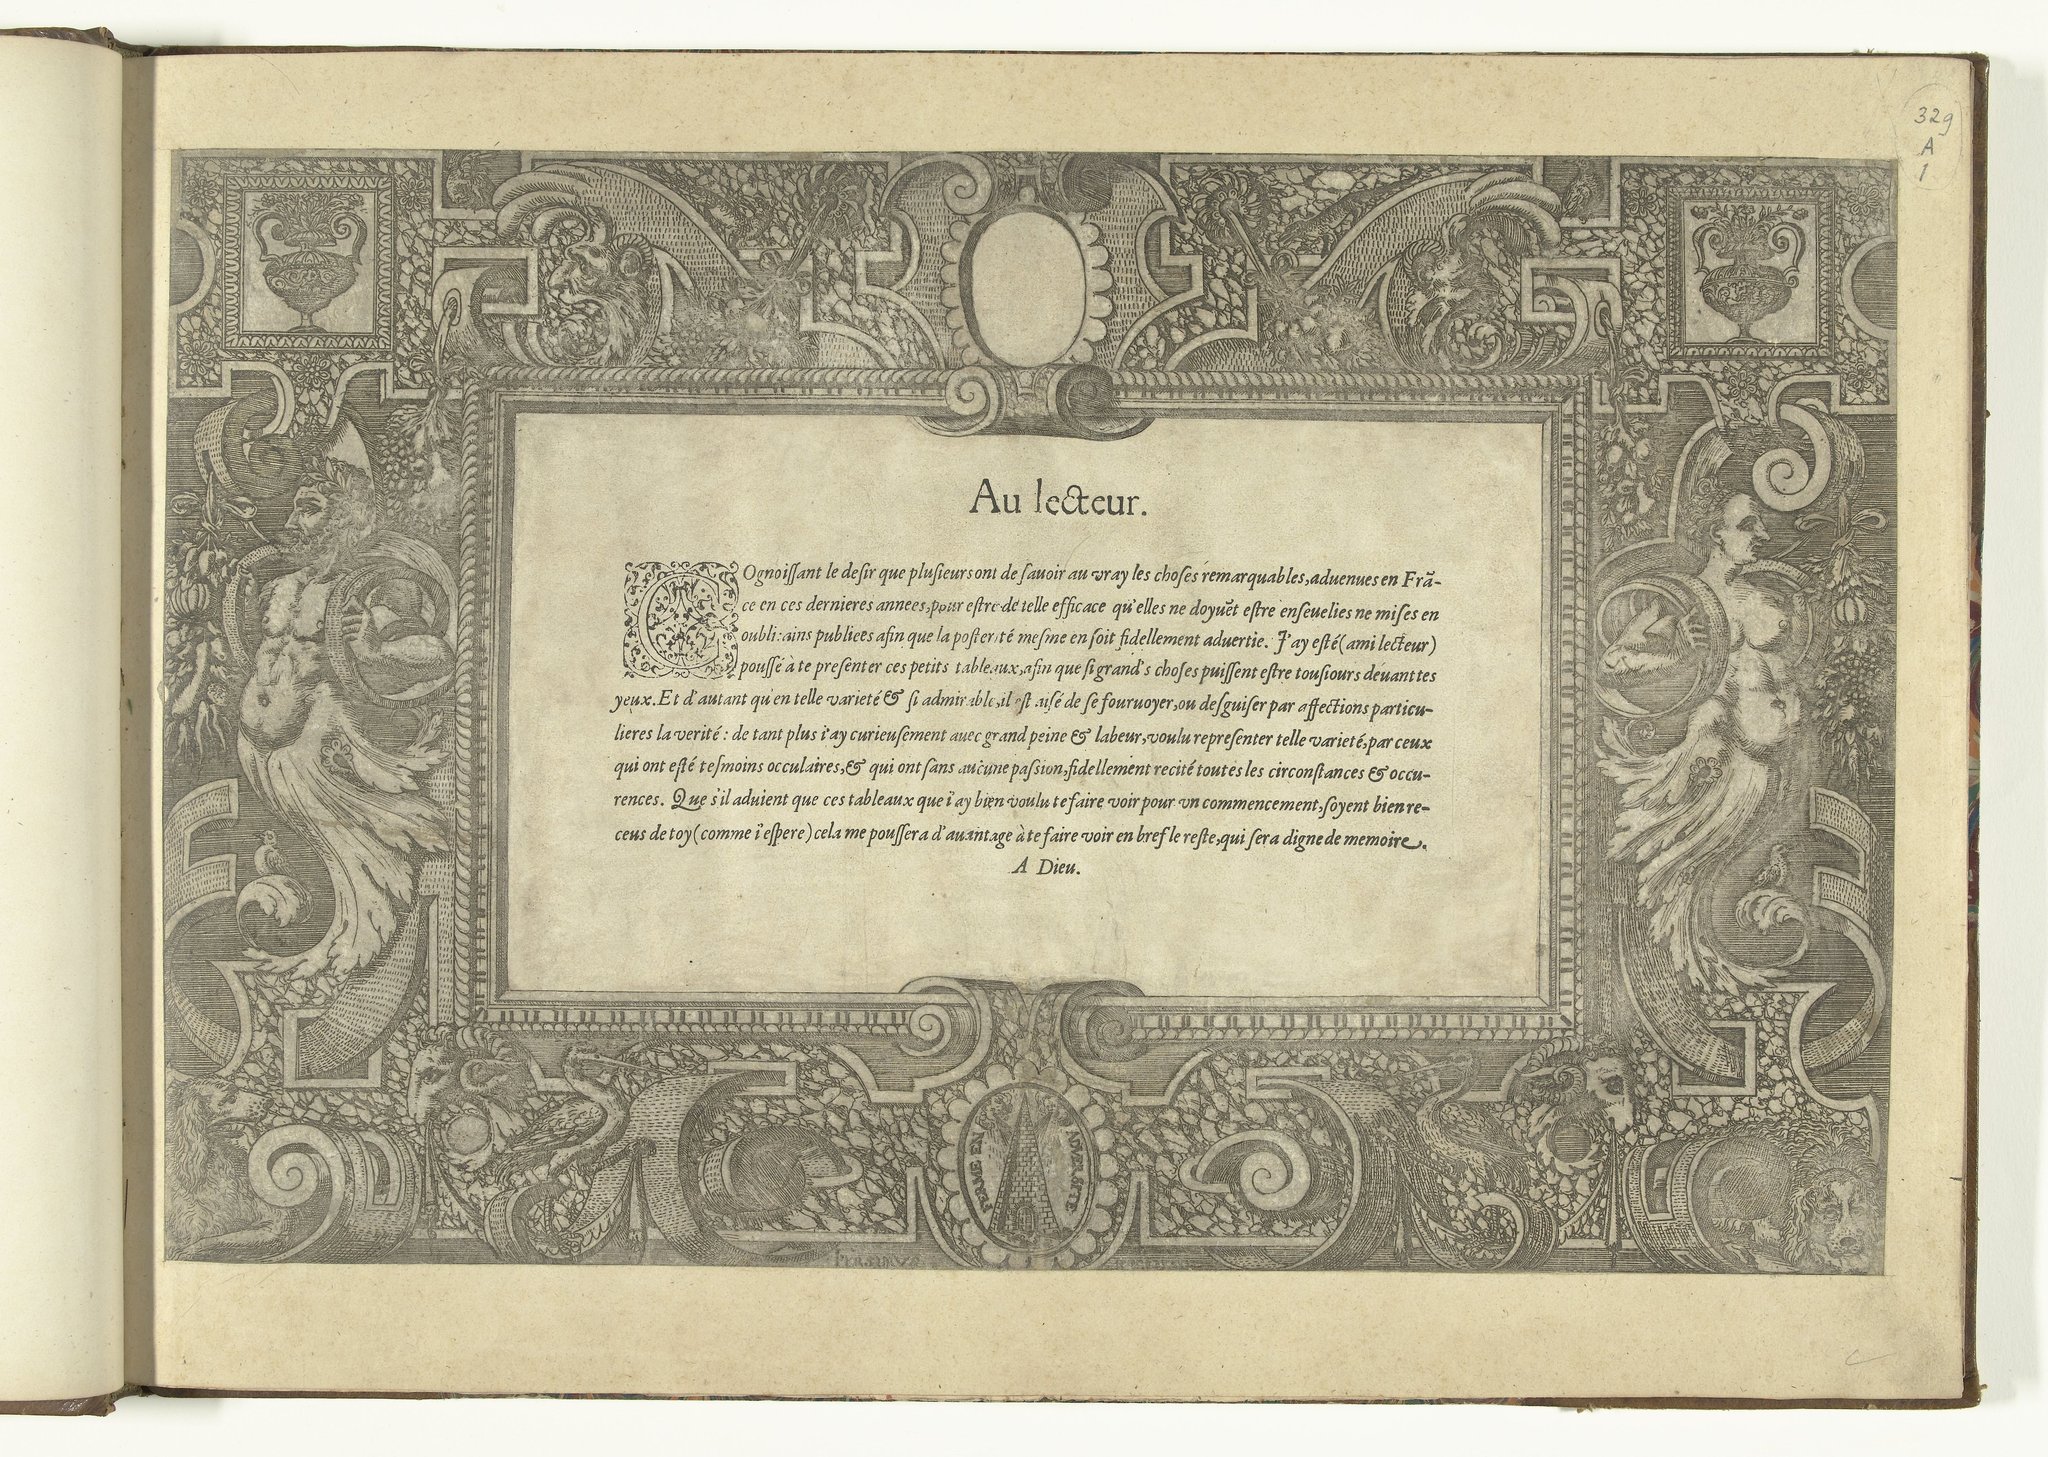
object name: print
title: Opdracht aan de lezer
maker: jean perrissin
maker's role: print maker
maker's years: 1536-1611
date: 1570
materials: paper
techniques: etching, letterpress printing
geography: france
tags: ornaments ~ art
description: Blad met een opdracht aan de lezer: Au lecteur. Cartouche met tekst van 10 regels in het Frans in boekdruk met een versierde initiaal in een ornamentele omlijsting met fantasiewezens, dieren (honden en reigers of ooievaars), mascarons, vazen, rolwerk etc. Onderaan een embleem van een stenen toren met de motto: Ferme en Adversite.